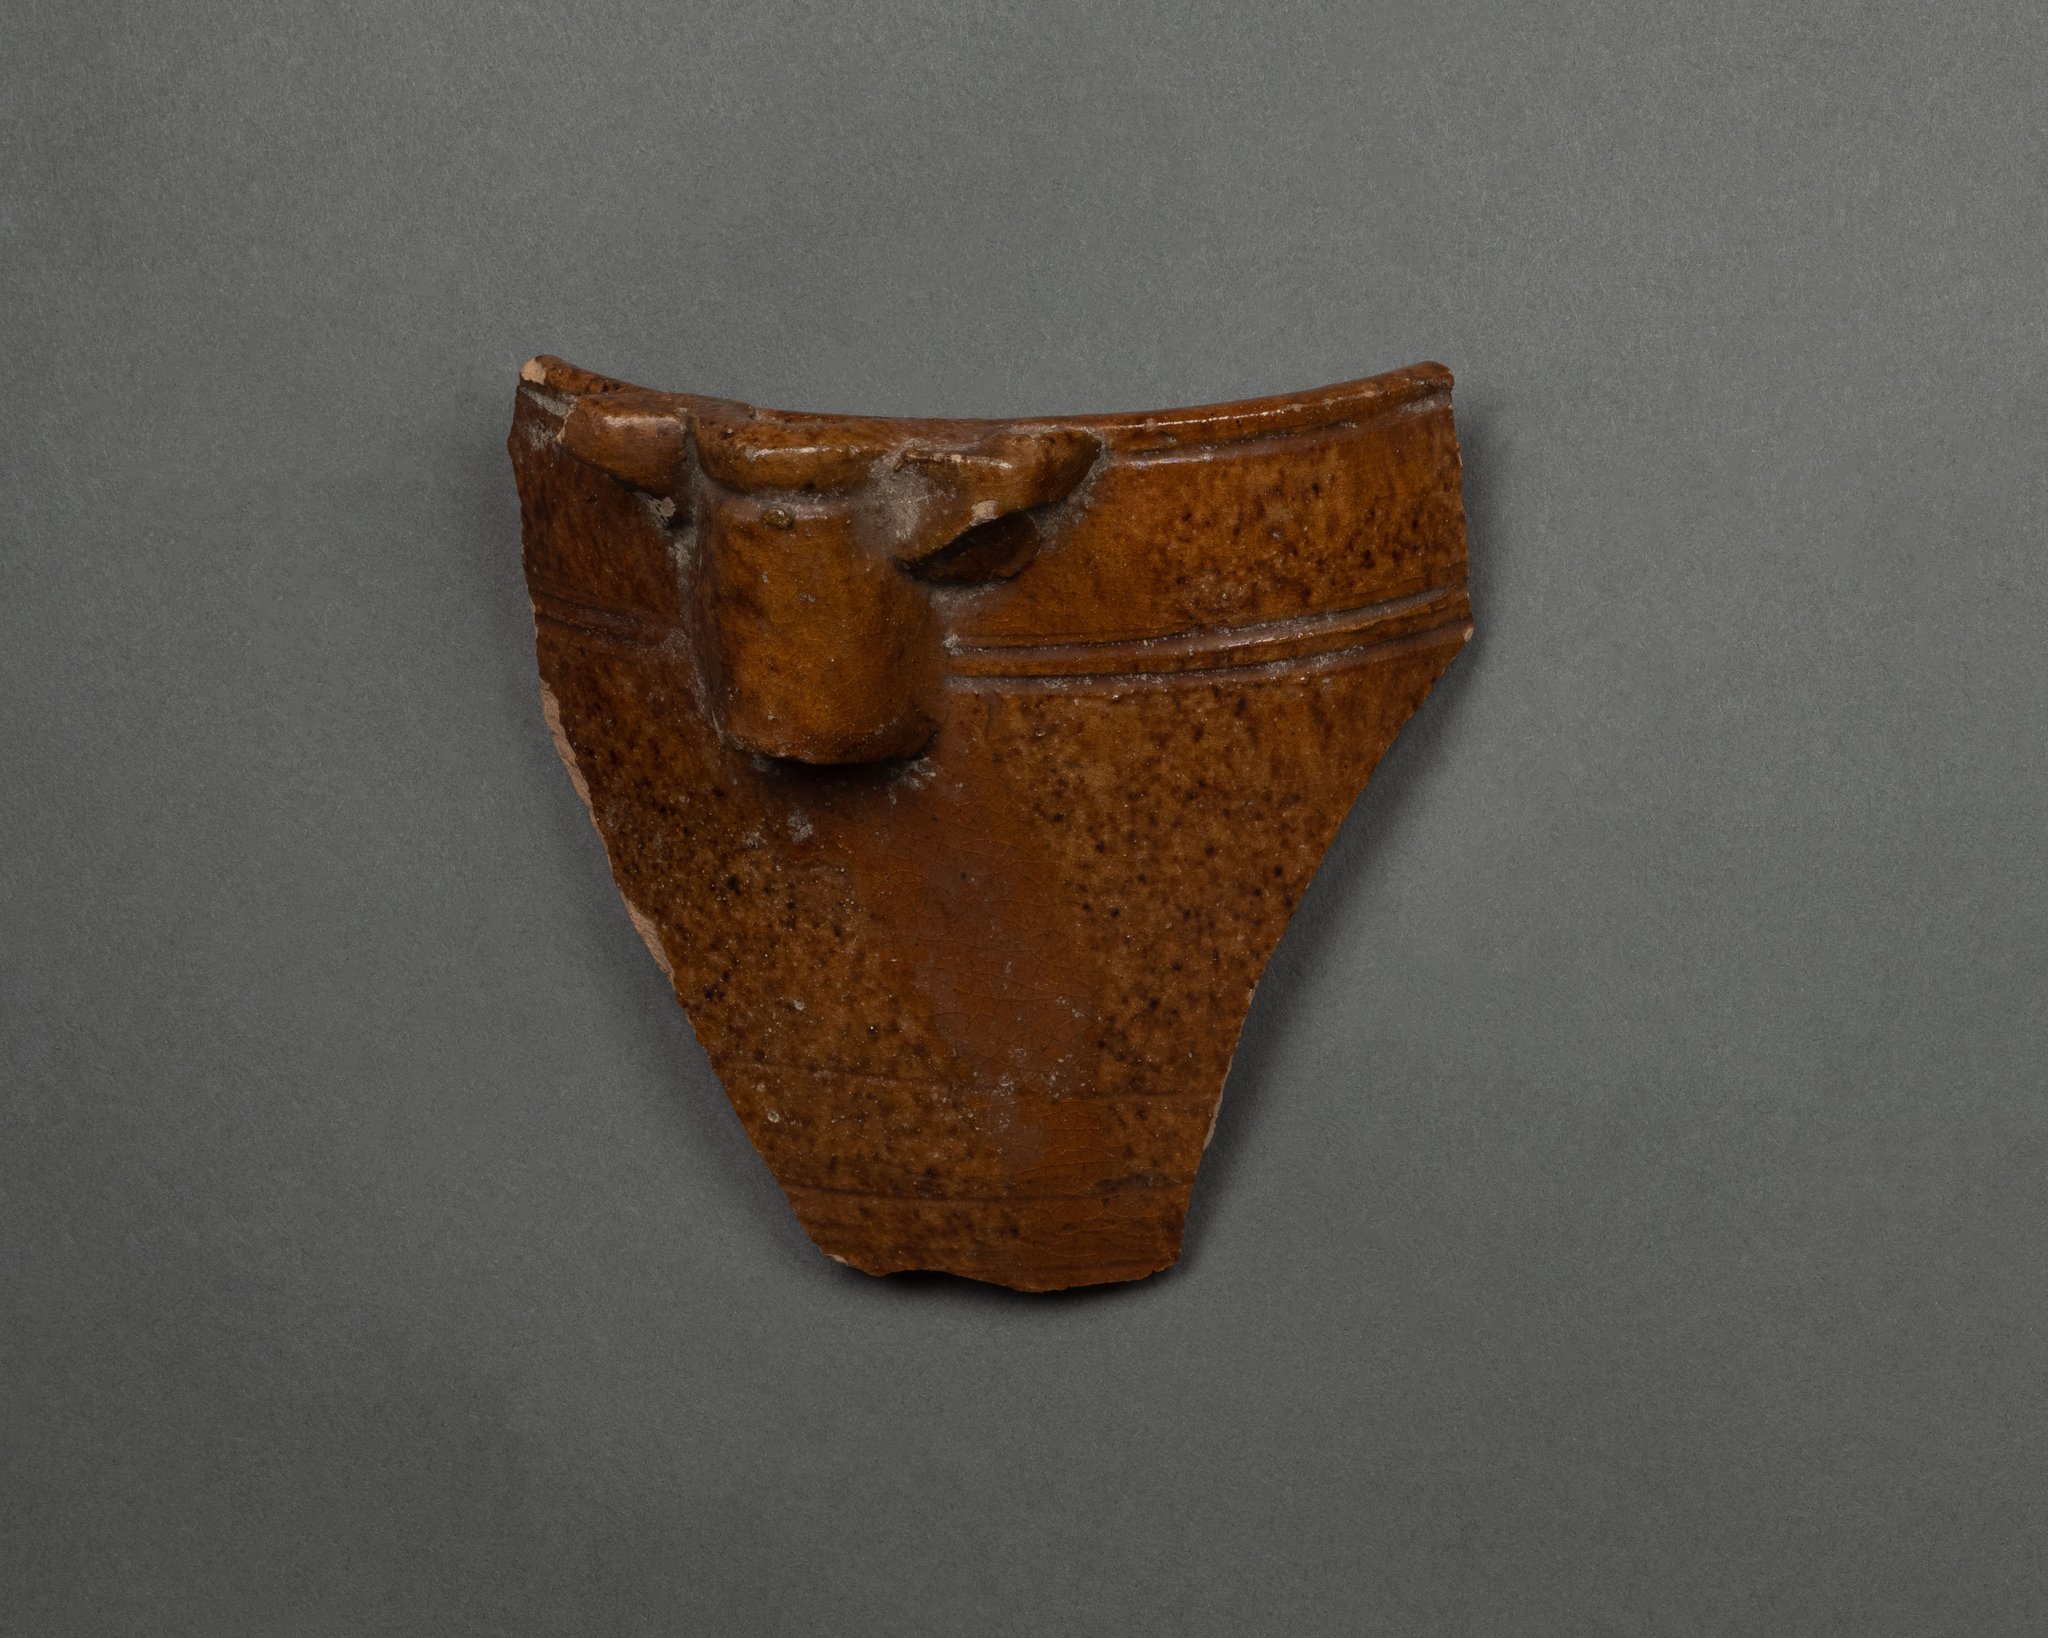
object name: vase fragment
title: Fragment of a Vase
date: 801-900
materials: earthenware, glaze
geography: iran